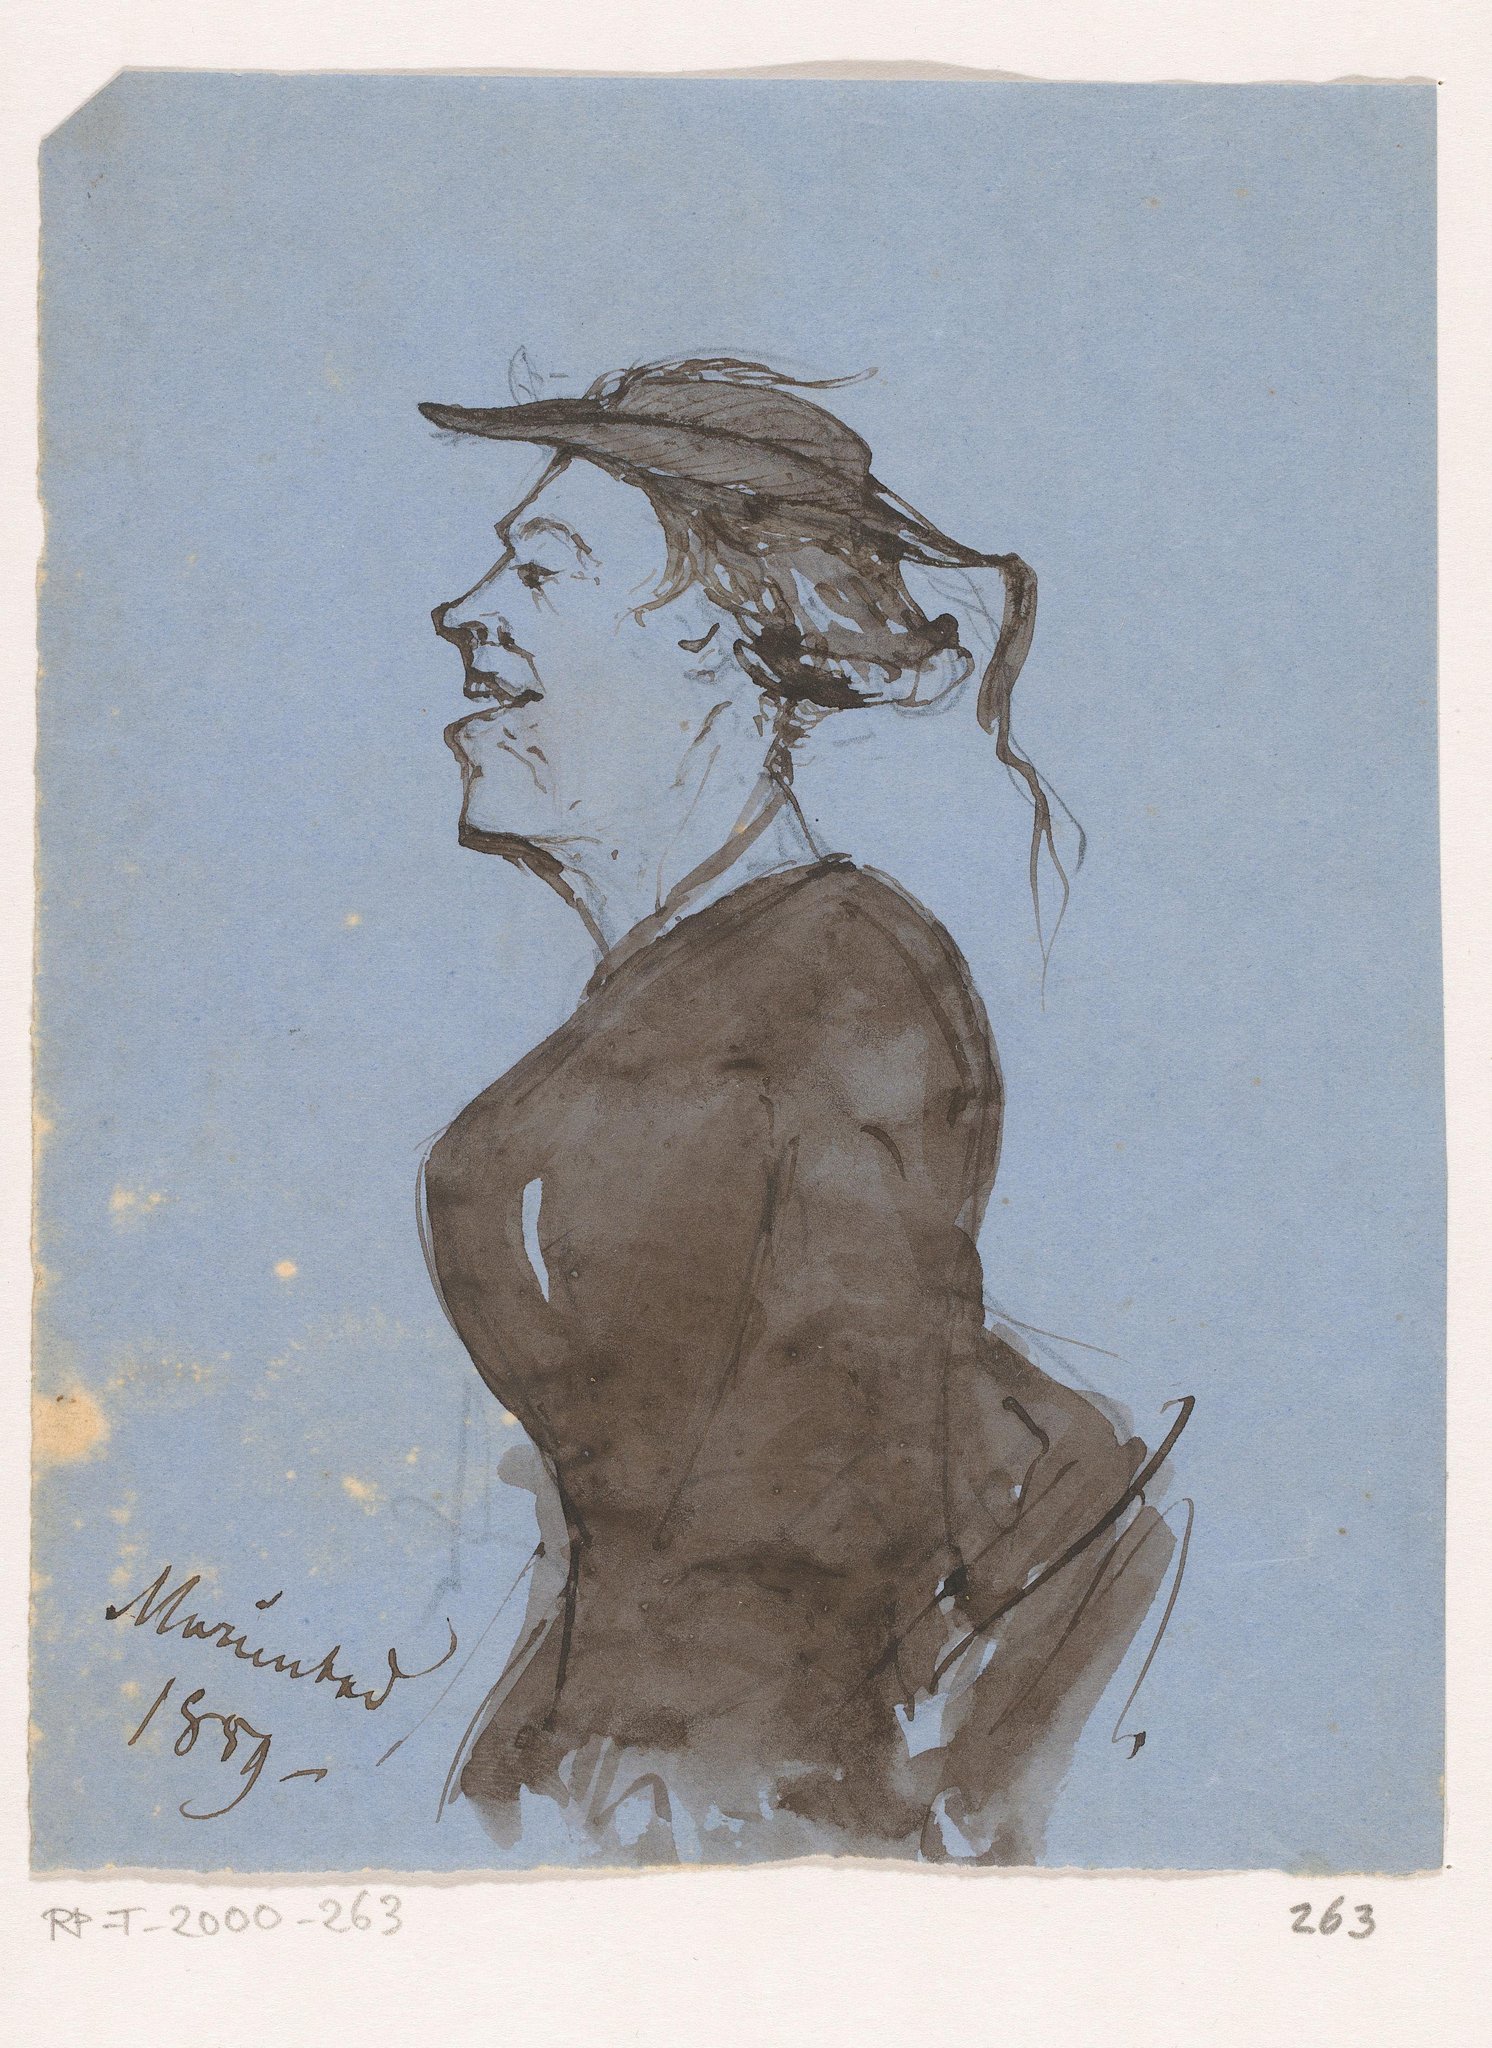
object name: drawing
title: Vrouw in Mariënbad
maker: johannes tavenraat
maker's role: draughtsman, painter, print maker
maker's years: 1809-1881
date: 1859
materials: ink, paper, pencil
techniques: brush, pen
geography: marienbad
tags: caricatures (human types), folk costume, regional costume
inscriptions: collector's mark: Lugt 2228, date and inscription: ‘Marienbad 1859’